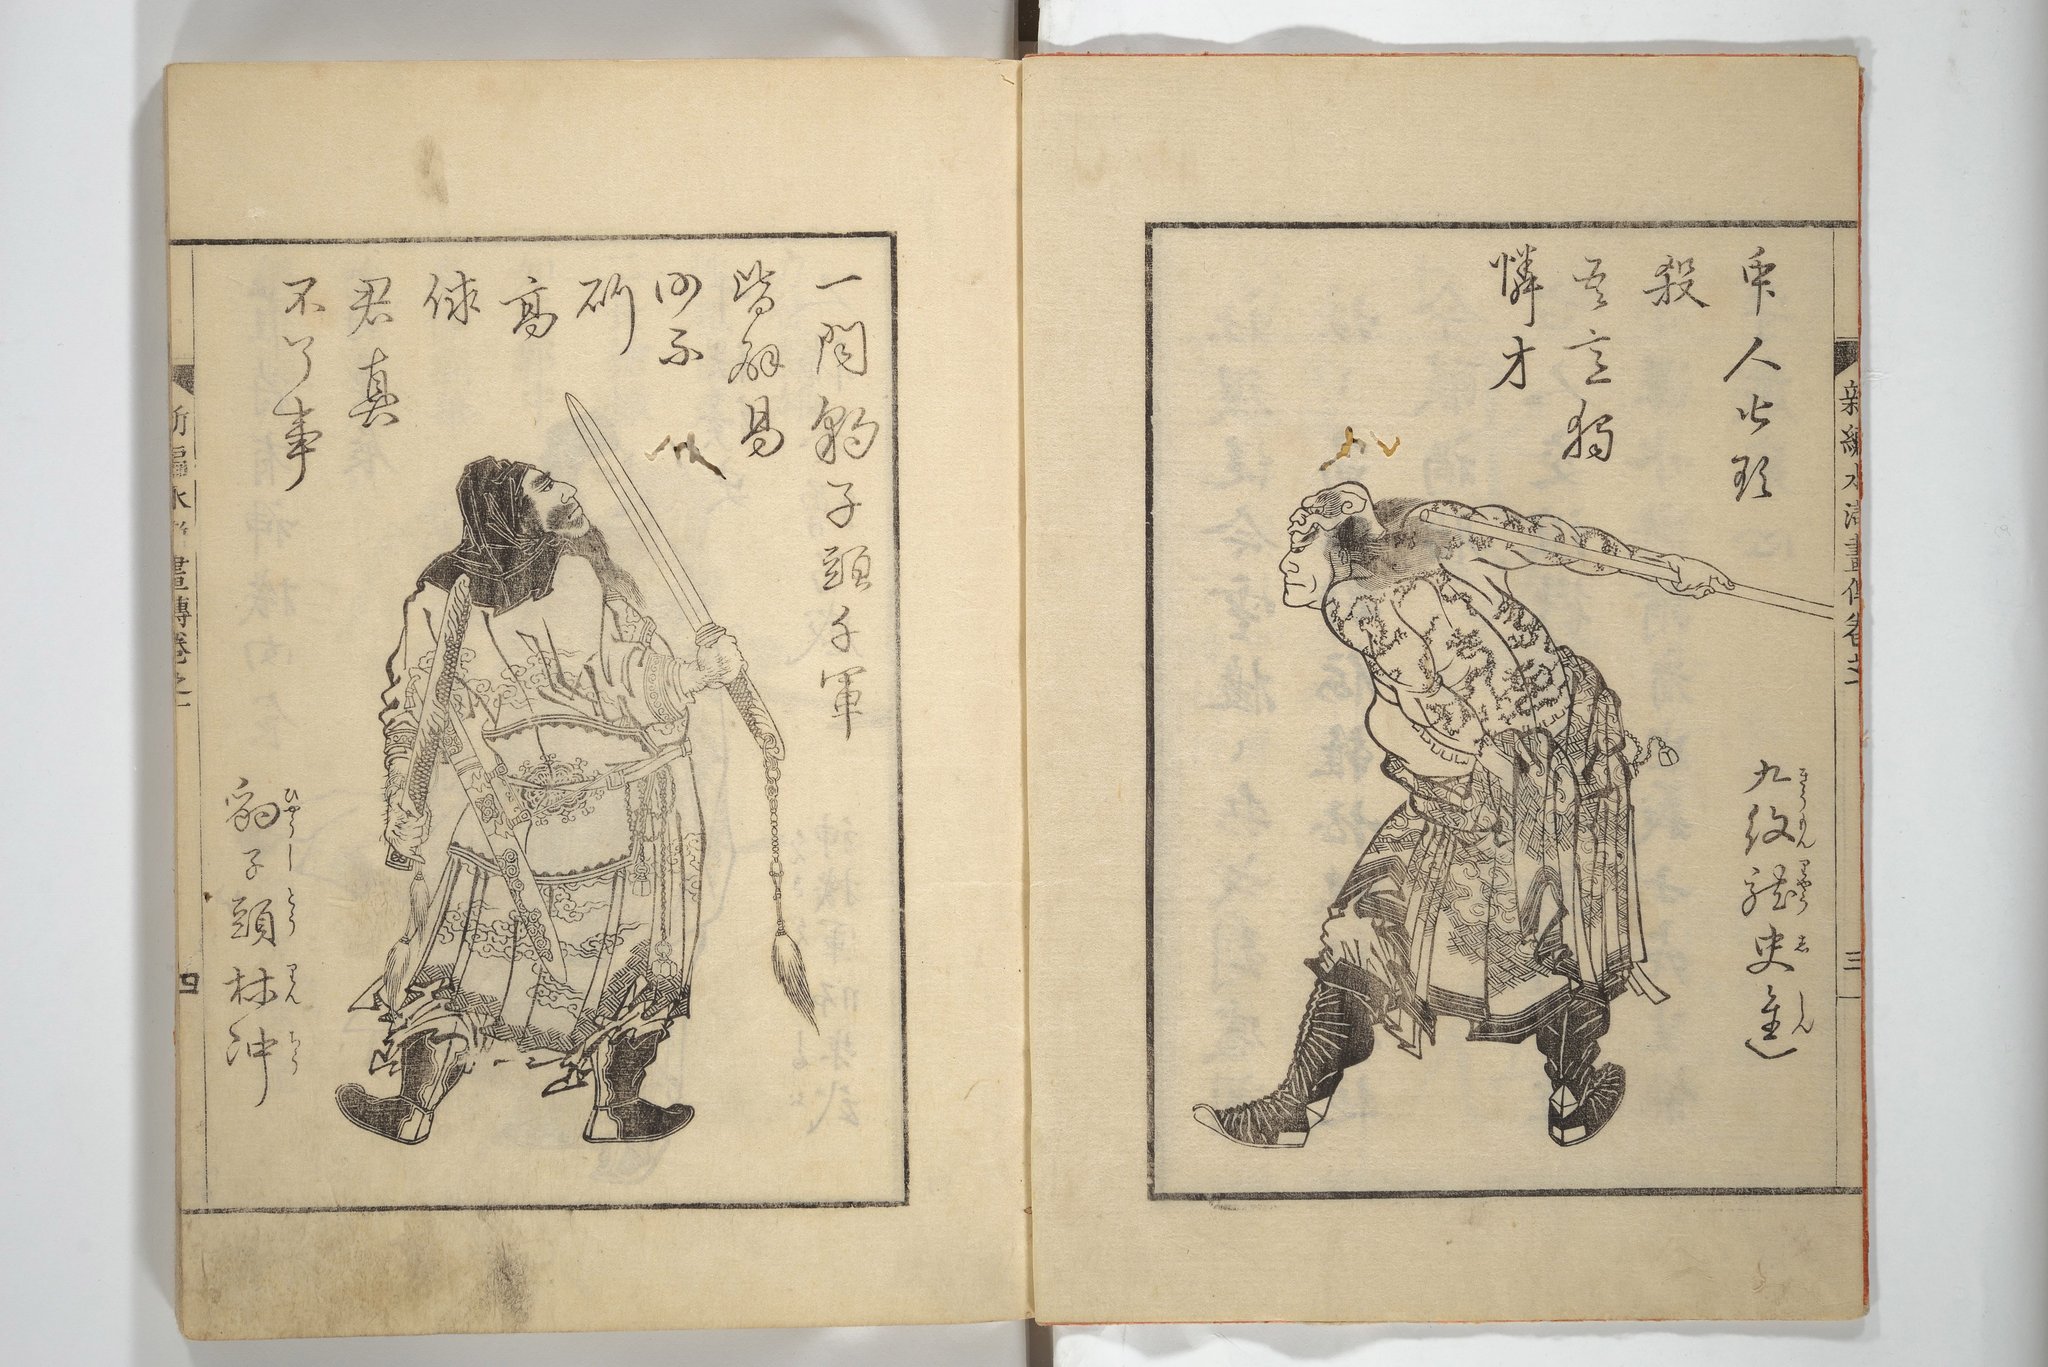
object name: illustrated book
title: An Illustrated New Edition of Suikoden (The Water Margin) (Shinpen suiko gaden) 新編水滸画伝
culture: japanese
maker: katsushika hokusai 葛飾北斎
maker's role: artist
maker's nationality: japanese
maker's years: 1760-1849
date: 1805-1838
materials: ink, paper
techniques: woodblock print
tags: swords,men